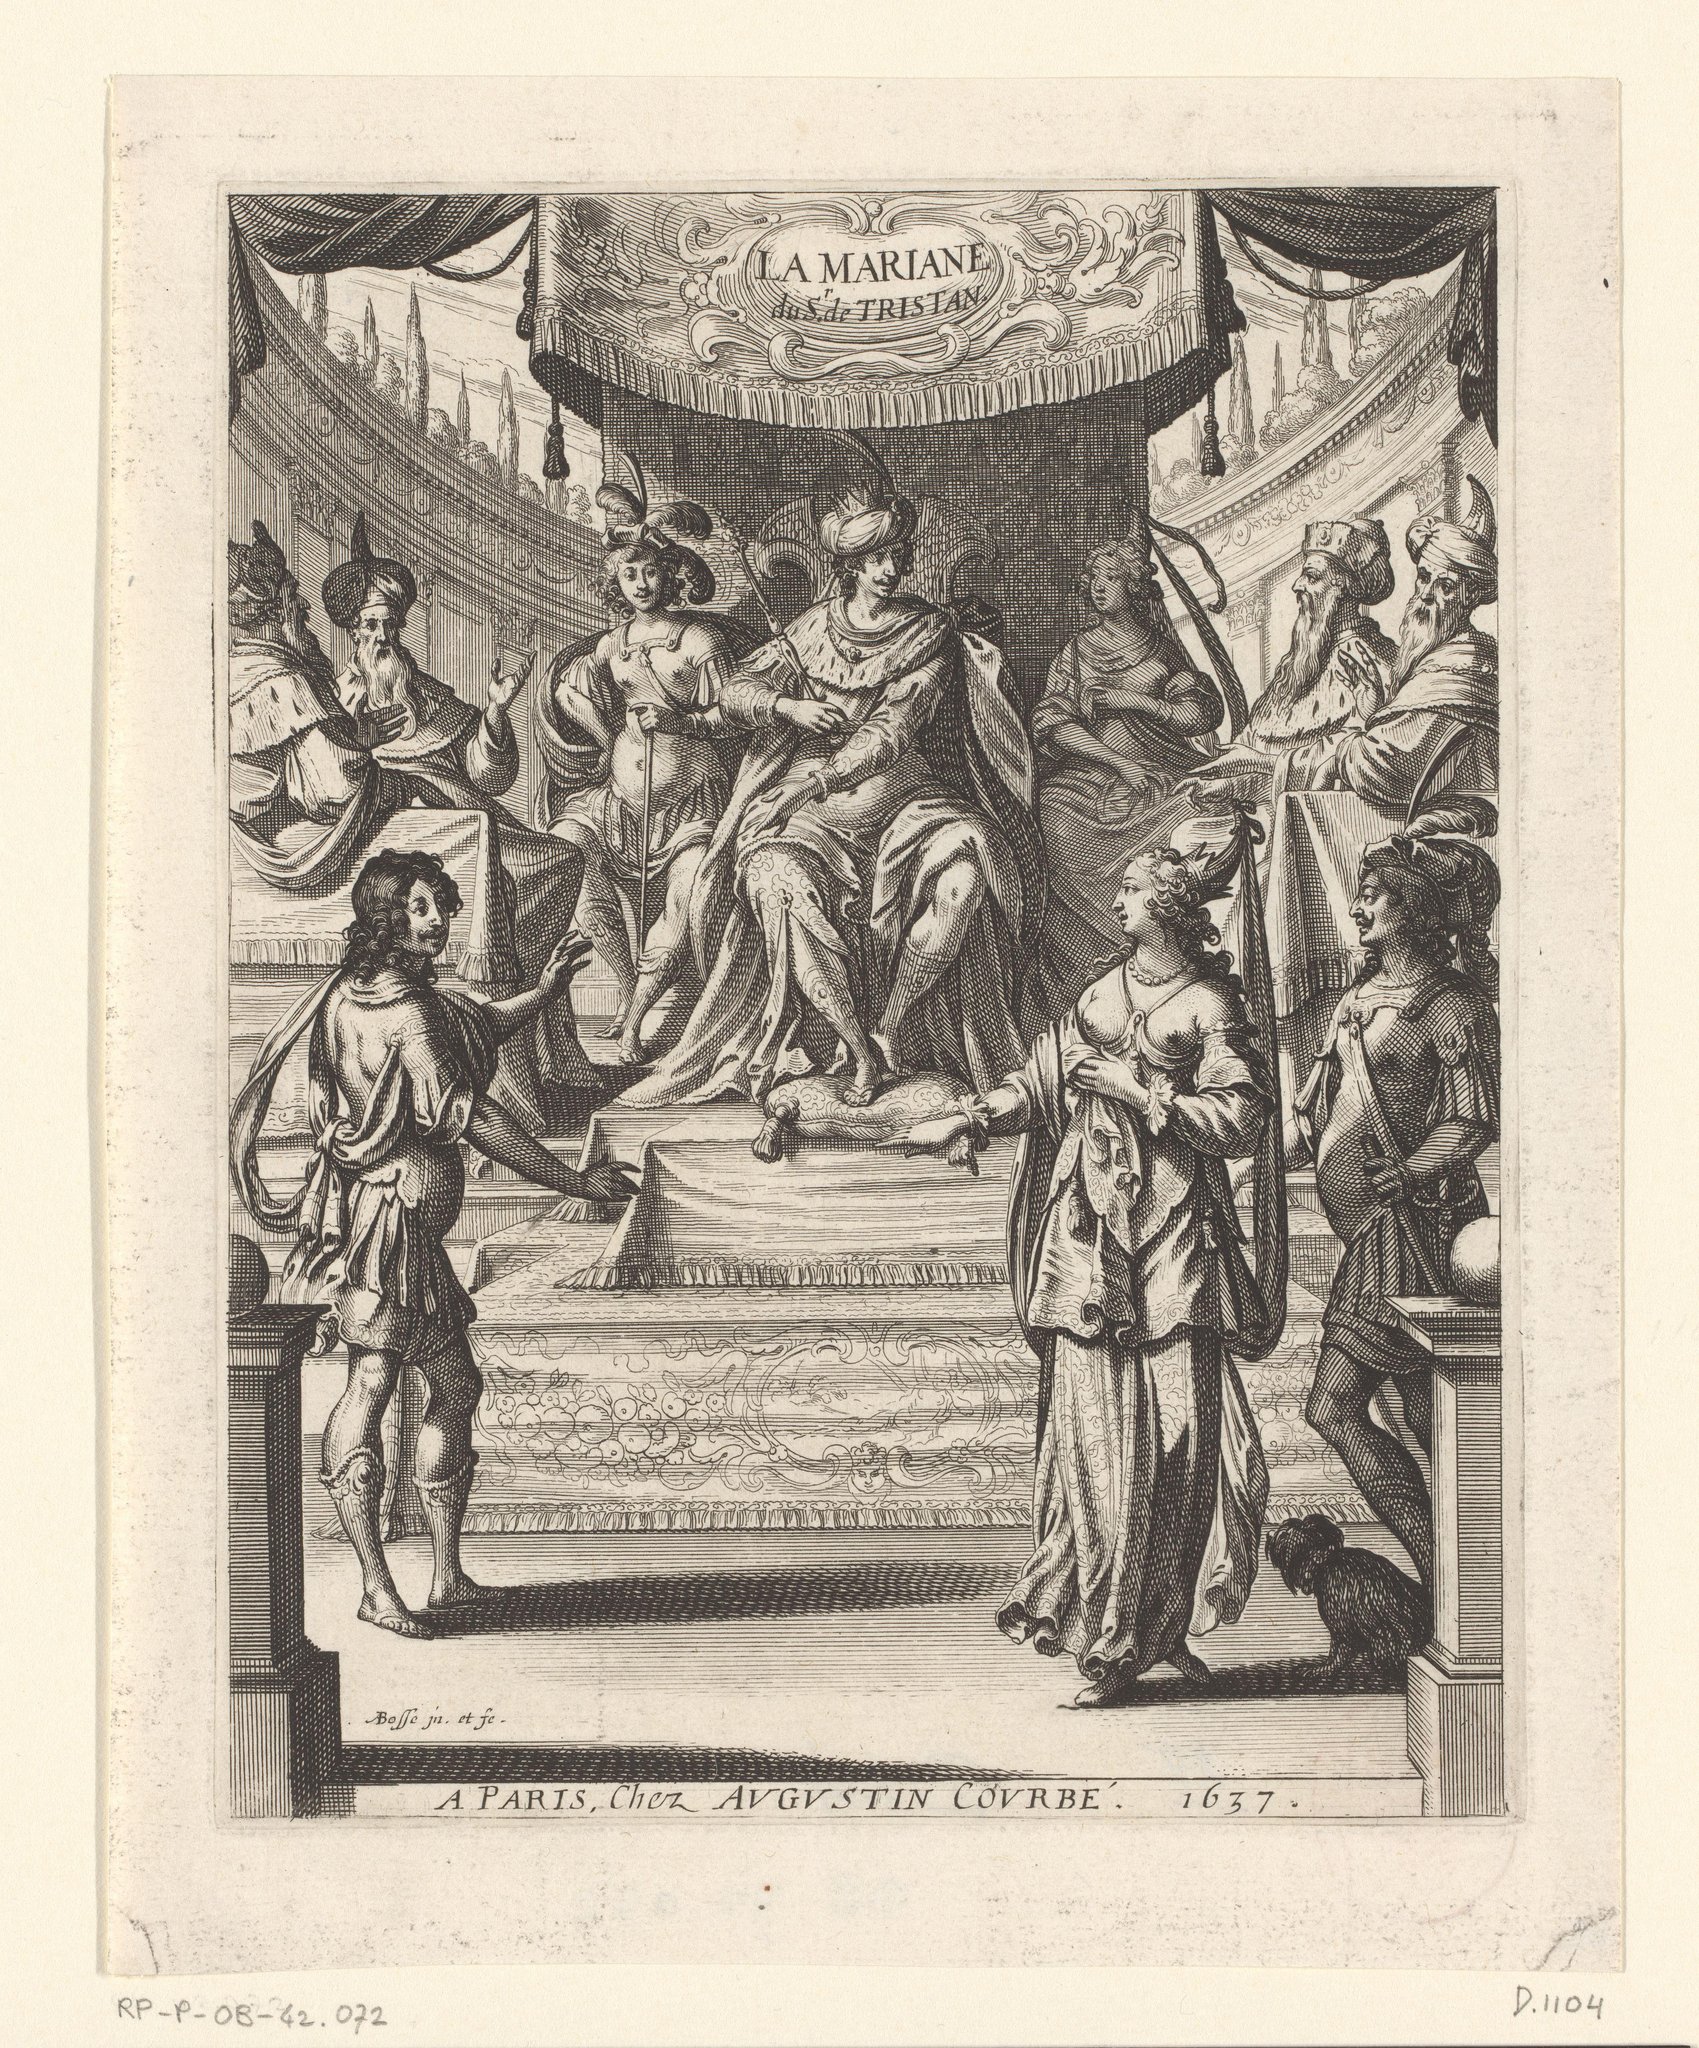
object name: print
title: Titelpagina voor: Tristan l'Hermite, La Mariane, 1637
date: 1637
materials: paper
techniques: engraving, etching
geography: paris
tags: canopy, baldachin, king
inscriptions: collector's mark: Lugt 240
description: Titelpagina voor: Tristan l'Hermite, La Mariane. Parijs: Courbé, Augustin, 1637.